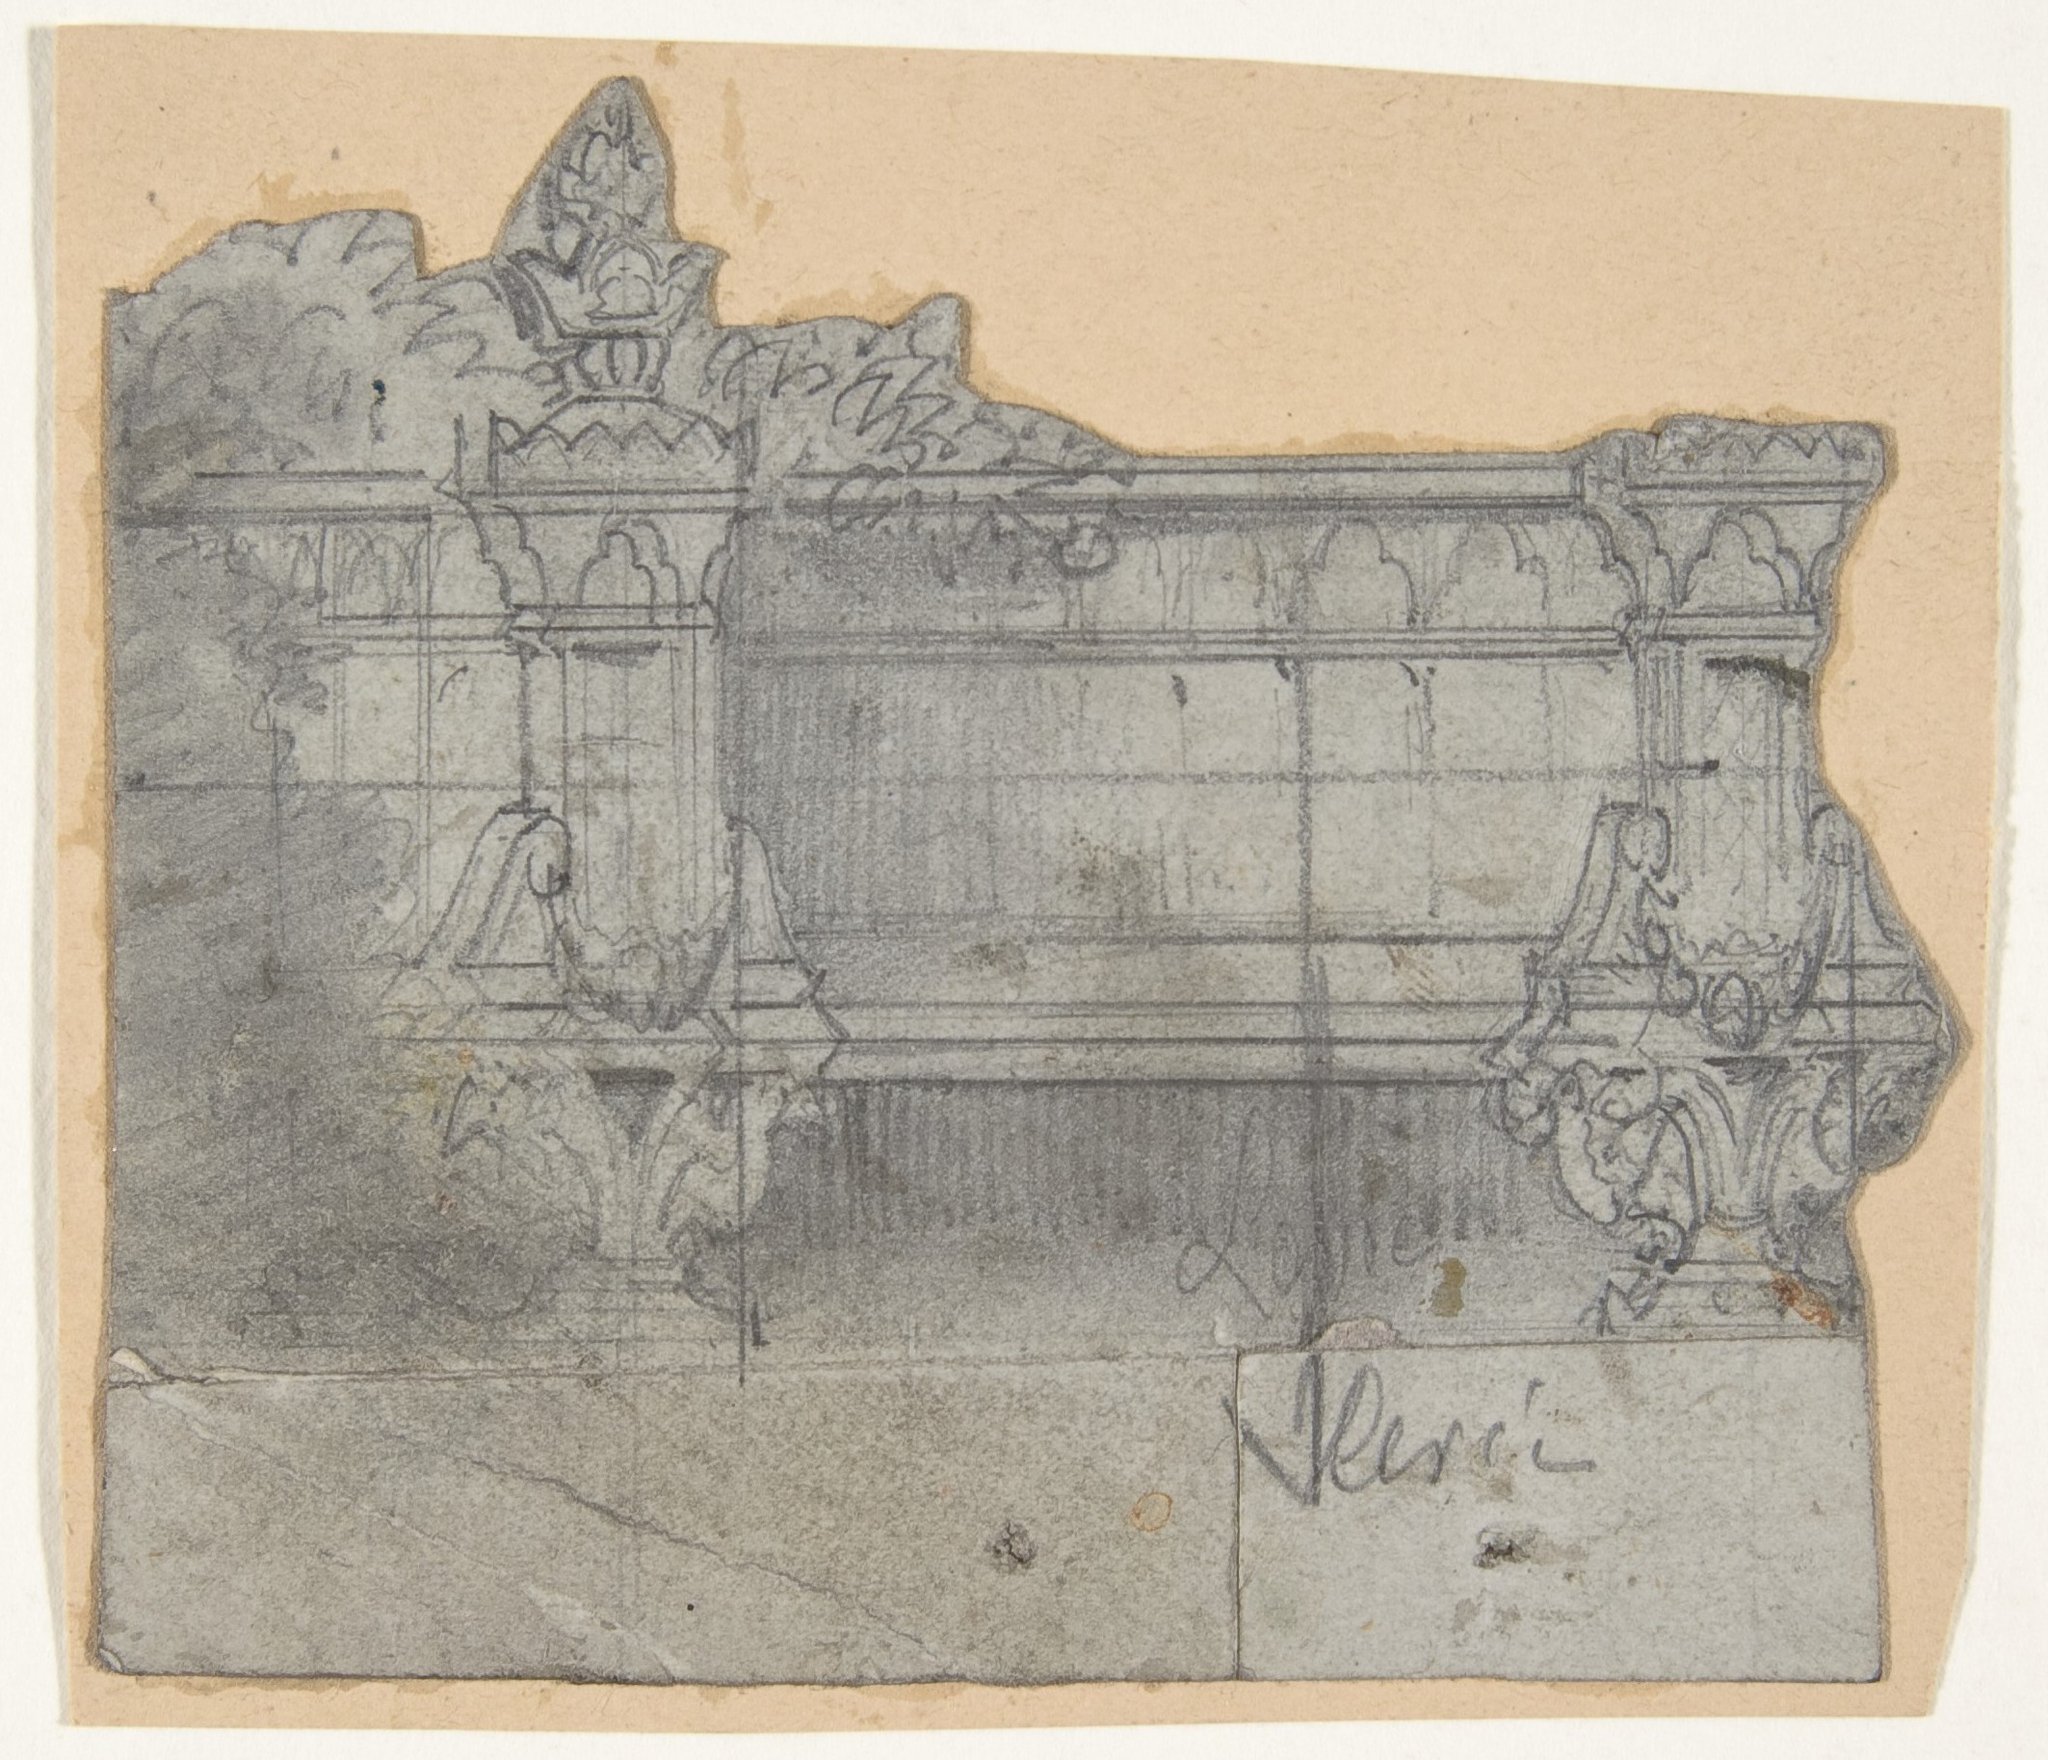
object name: drawing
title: Design for a Stage Set at the Opéra, Paris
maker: eugène cicéri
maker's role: artist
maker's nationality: french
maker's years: 1813-1890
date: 1830-1890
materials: graphite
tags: stage design